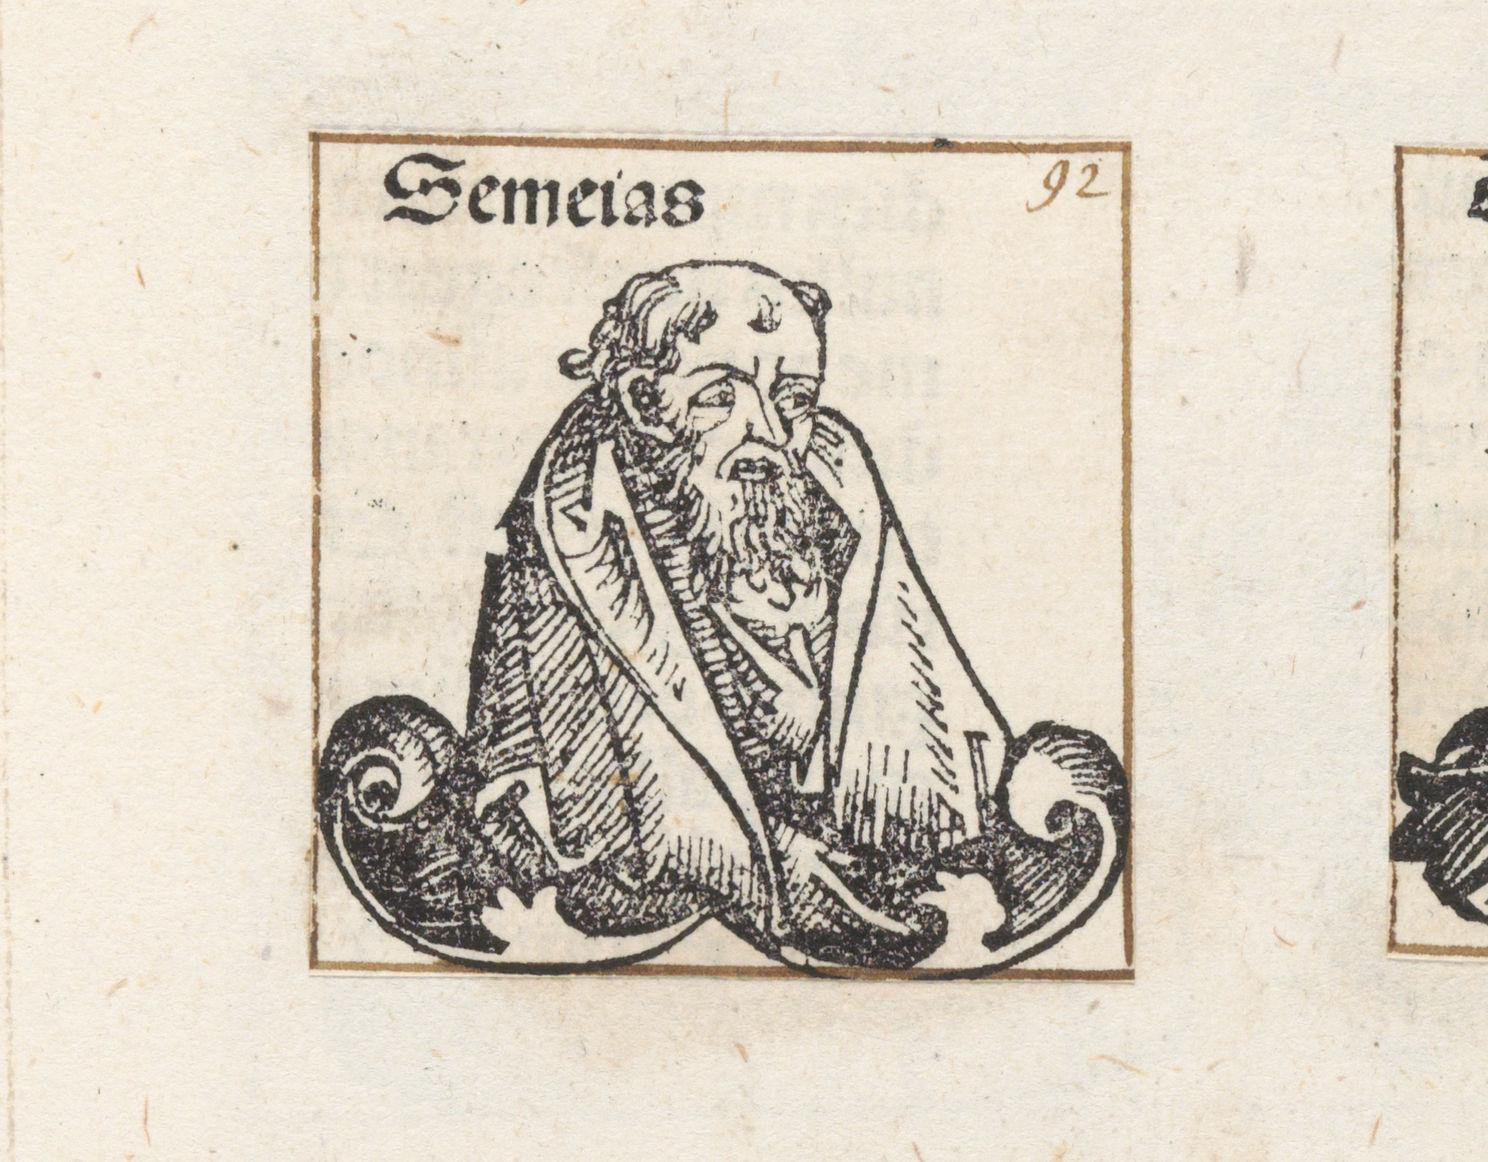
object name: album leaf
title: Semeias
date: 1493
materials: paper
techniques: letterpress printing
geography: nuremberg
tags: persons from the old testament (not in biblical context, nor occurring in legendary/historical extensions included in division 71)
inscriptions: inscription: ‘92’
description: De houtsnede wordt gebruikt als boekillustratie in de Liber Chronicarum (of Neurenbergkroniek) van Hartmann Schedel, verschenen in het Latijn en Duits in 1493. Zie de Latijnse uitgave, folio 48r.